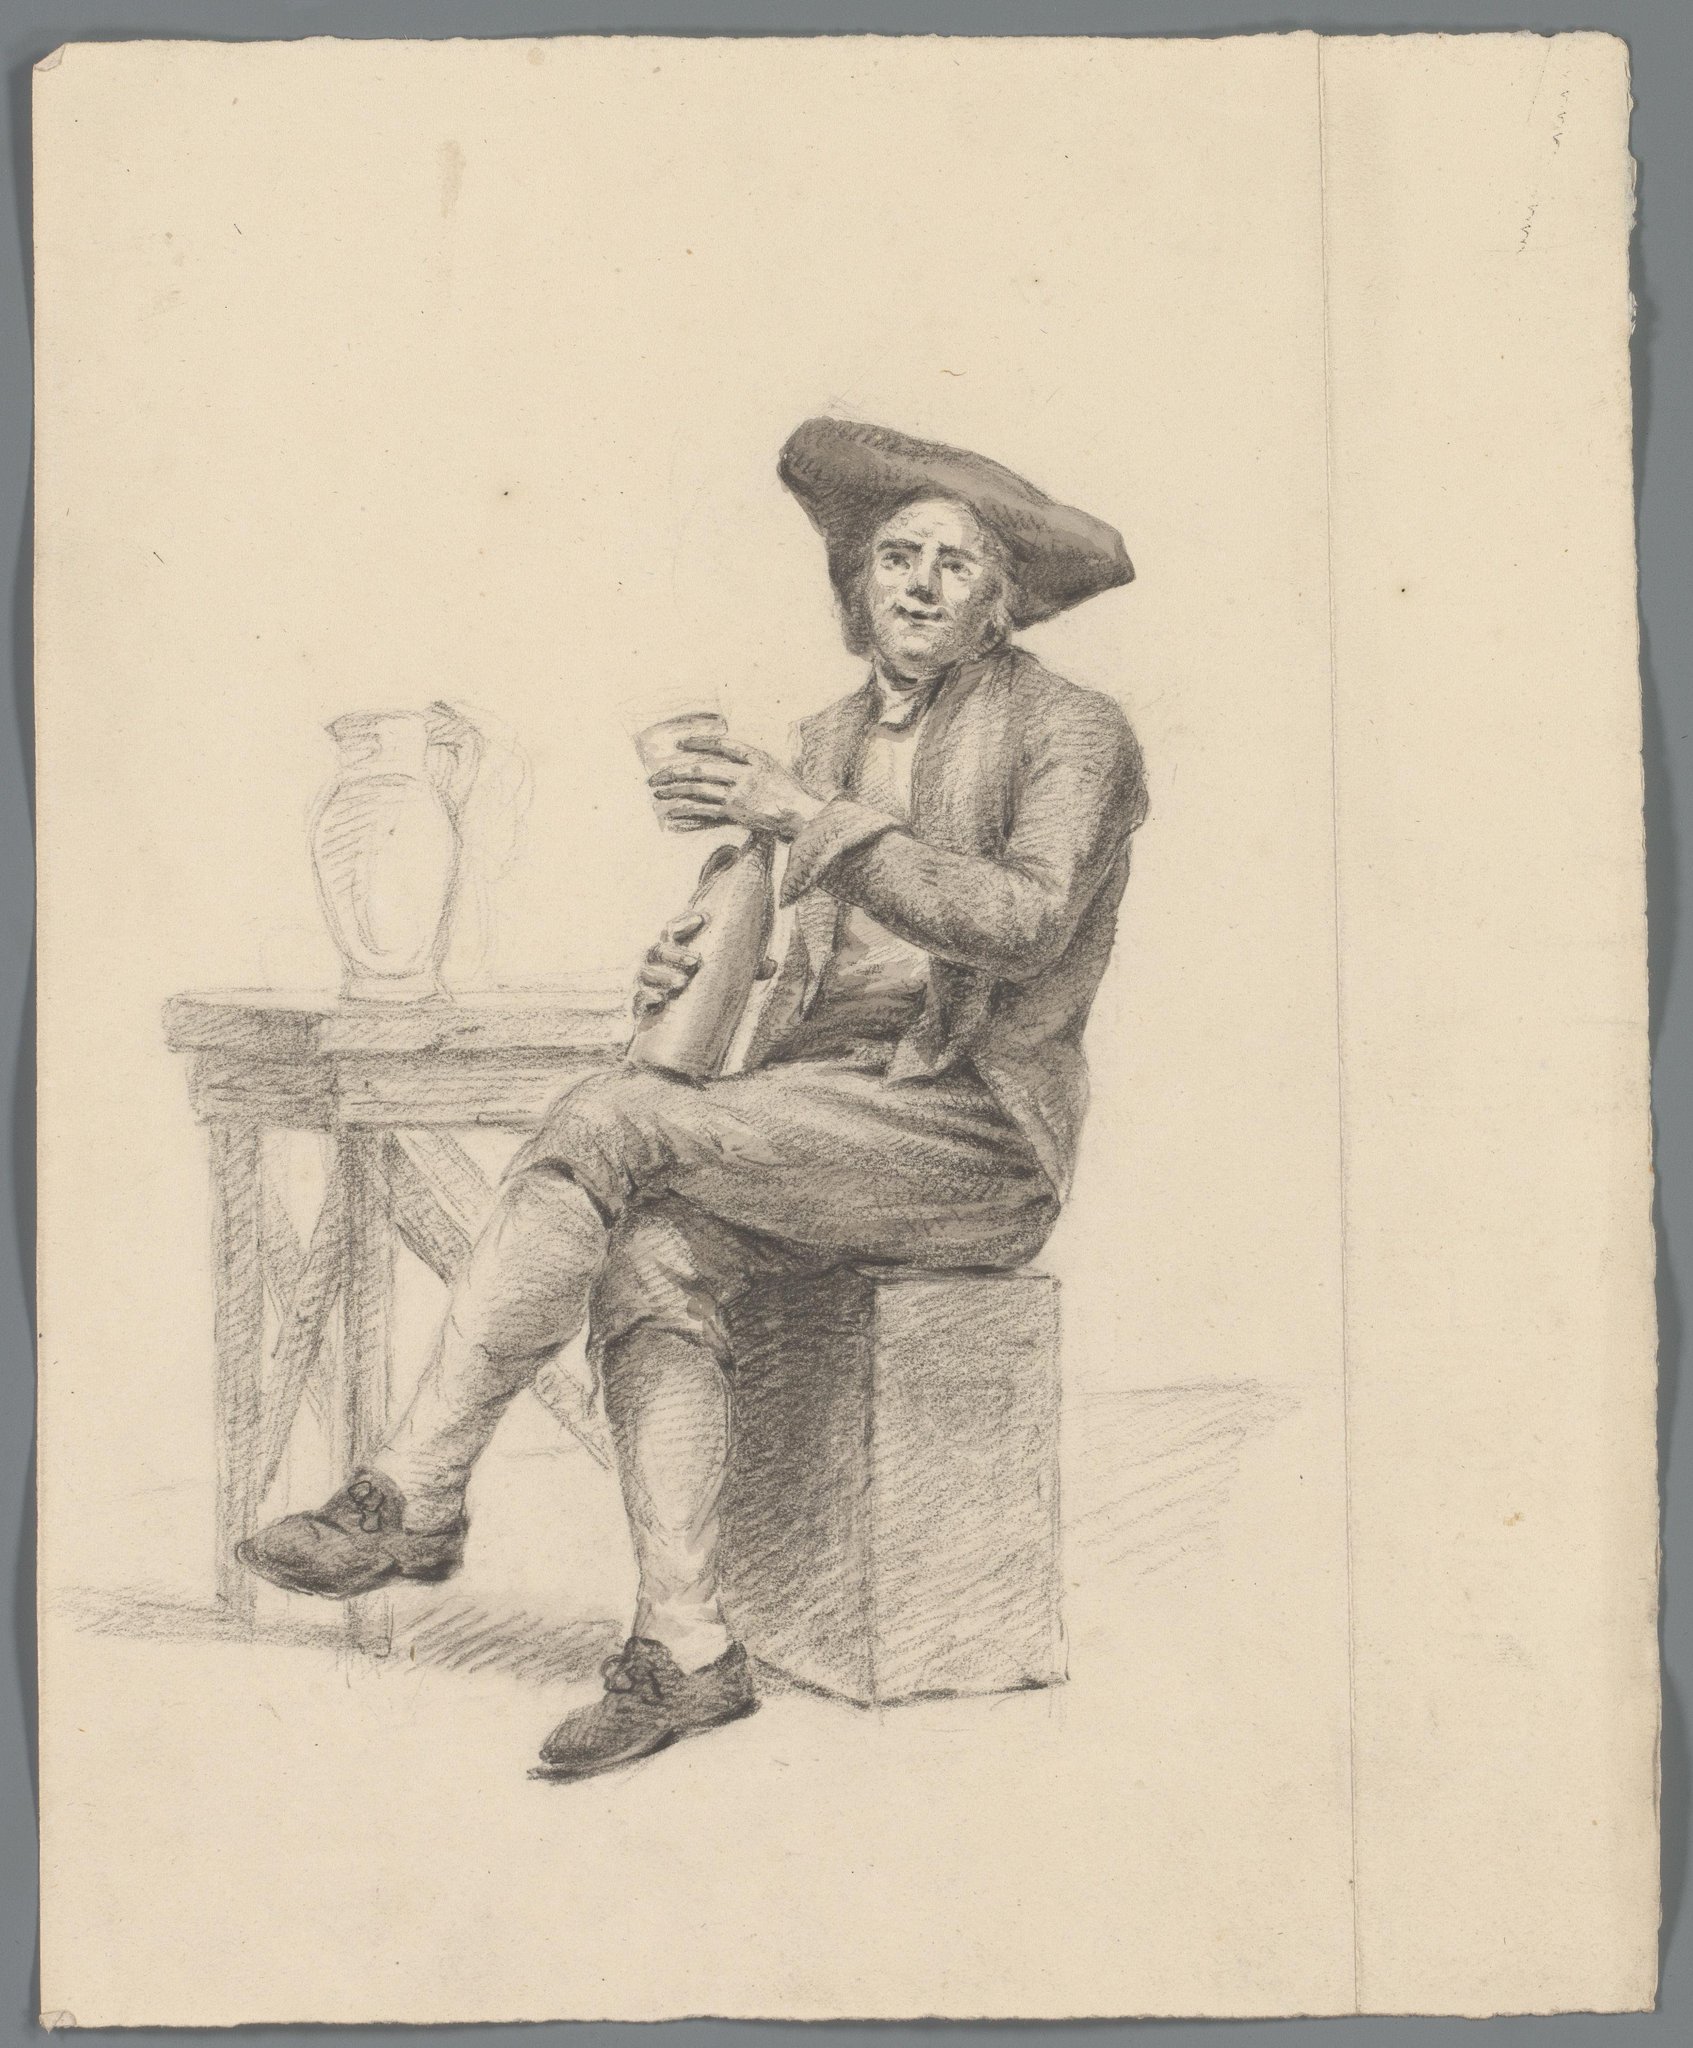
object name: drawing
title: Zittende man met een fles en glas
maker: Anonymous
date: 1820-1830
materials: chalk, paper, watercolor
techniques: brush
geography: the hague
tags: sitting figure, adult man, drinking-vessels, drinking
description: Tekeningen waarschijnlijk ontstaan bij het Haagse kunstgenootschap ‘Tot Nut der Tekenkunst’, waar twee keer per week tekenavonden werden georganiseerd met geklede modellen.